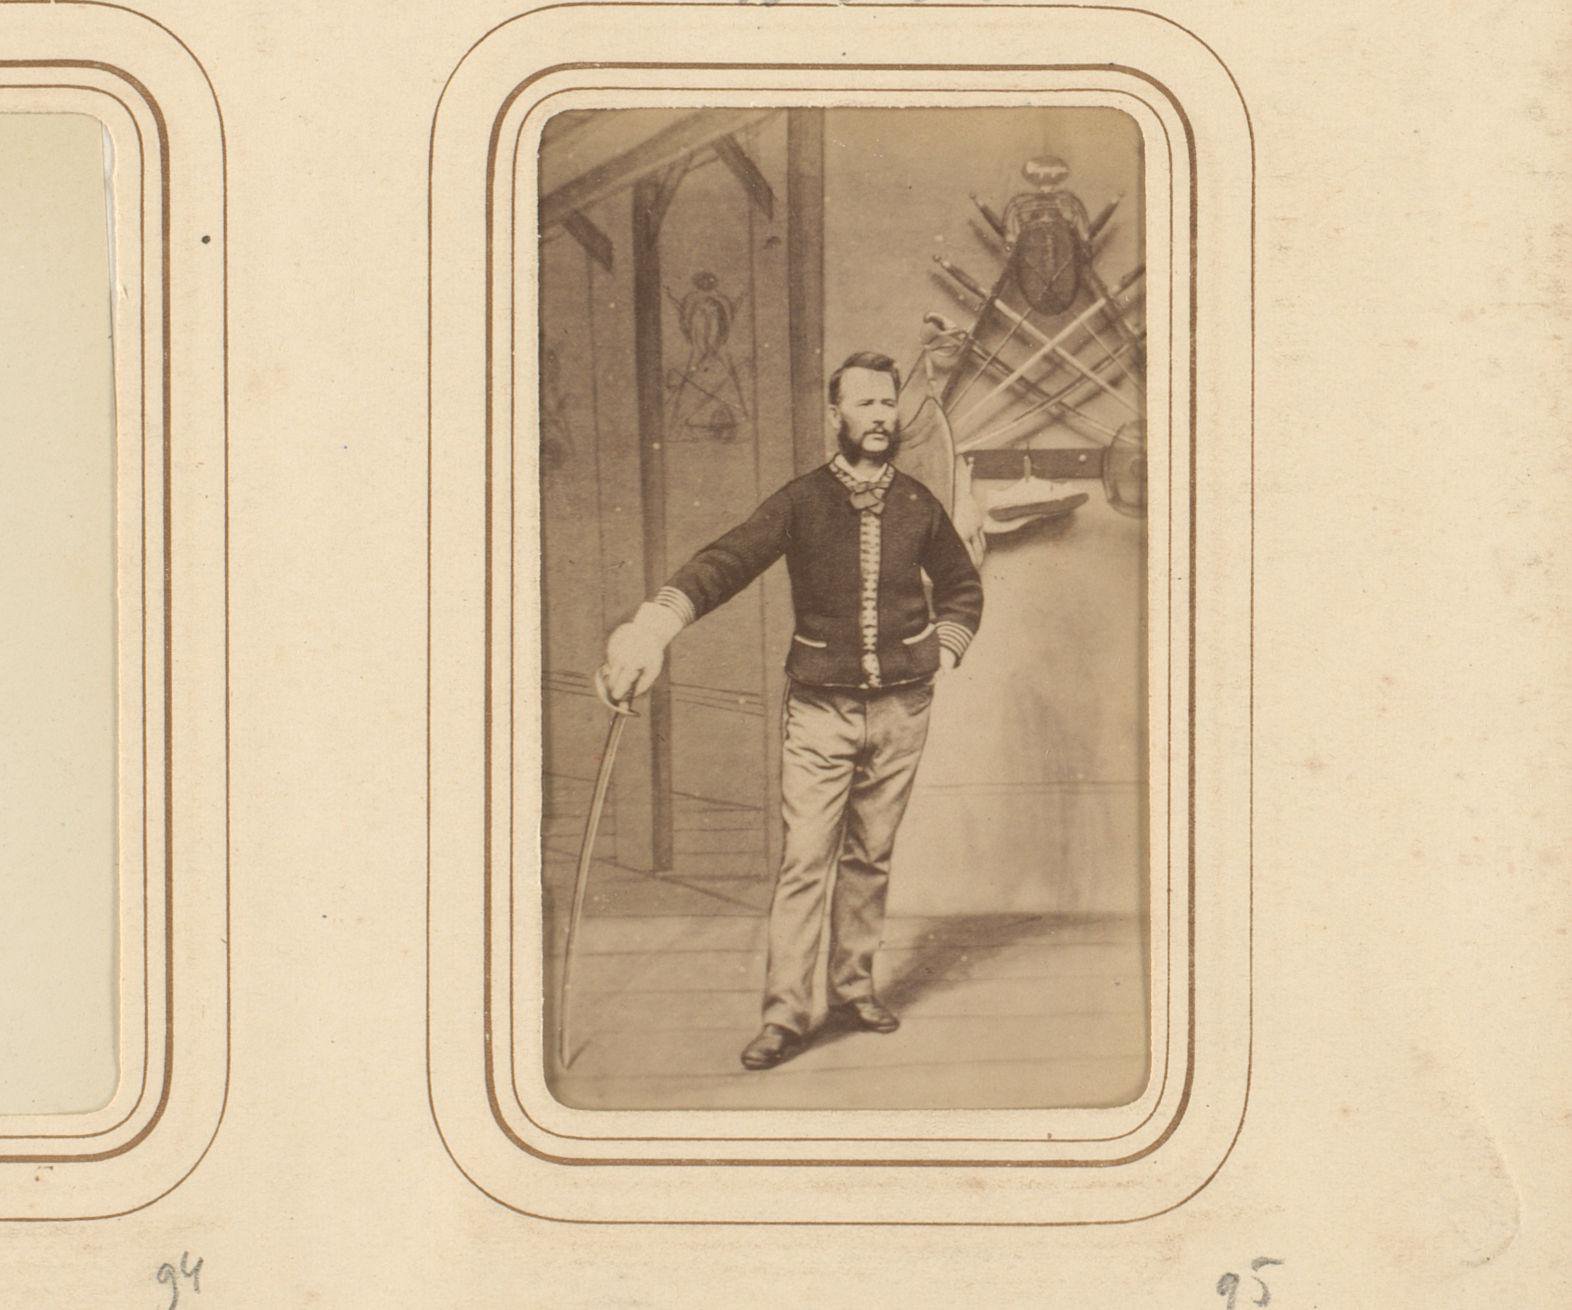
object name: album leaf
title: Portret van een man in een schermlokaal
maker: gustav albert fredrich christoph lüssow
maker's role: fotograaf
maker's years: 1837-1910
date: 1865-1885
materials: cardboard, photographic support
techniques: albumen print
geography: utrecht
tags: historical persons, fencing (sport)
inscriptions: inscription: ‘Photograph: / artistisches / Atelier / von / A. Lüssow / Utrecht / Keizerstraat by de Zonstraat Wyk G. 470’, inscription: ‘A. LÜSSOW UTRECHT’